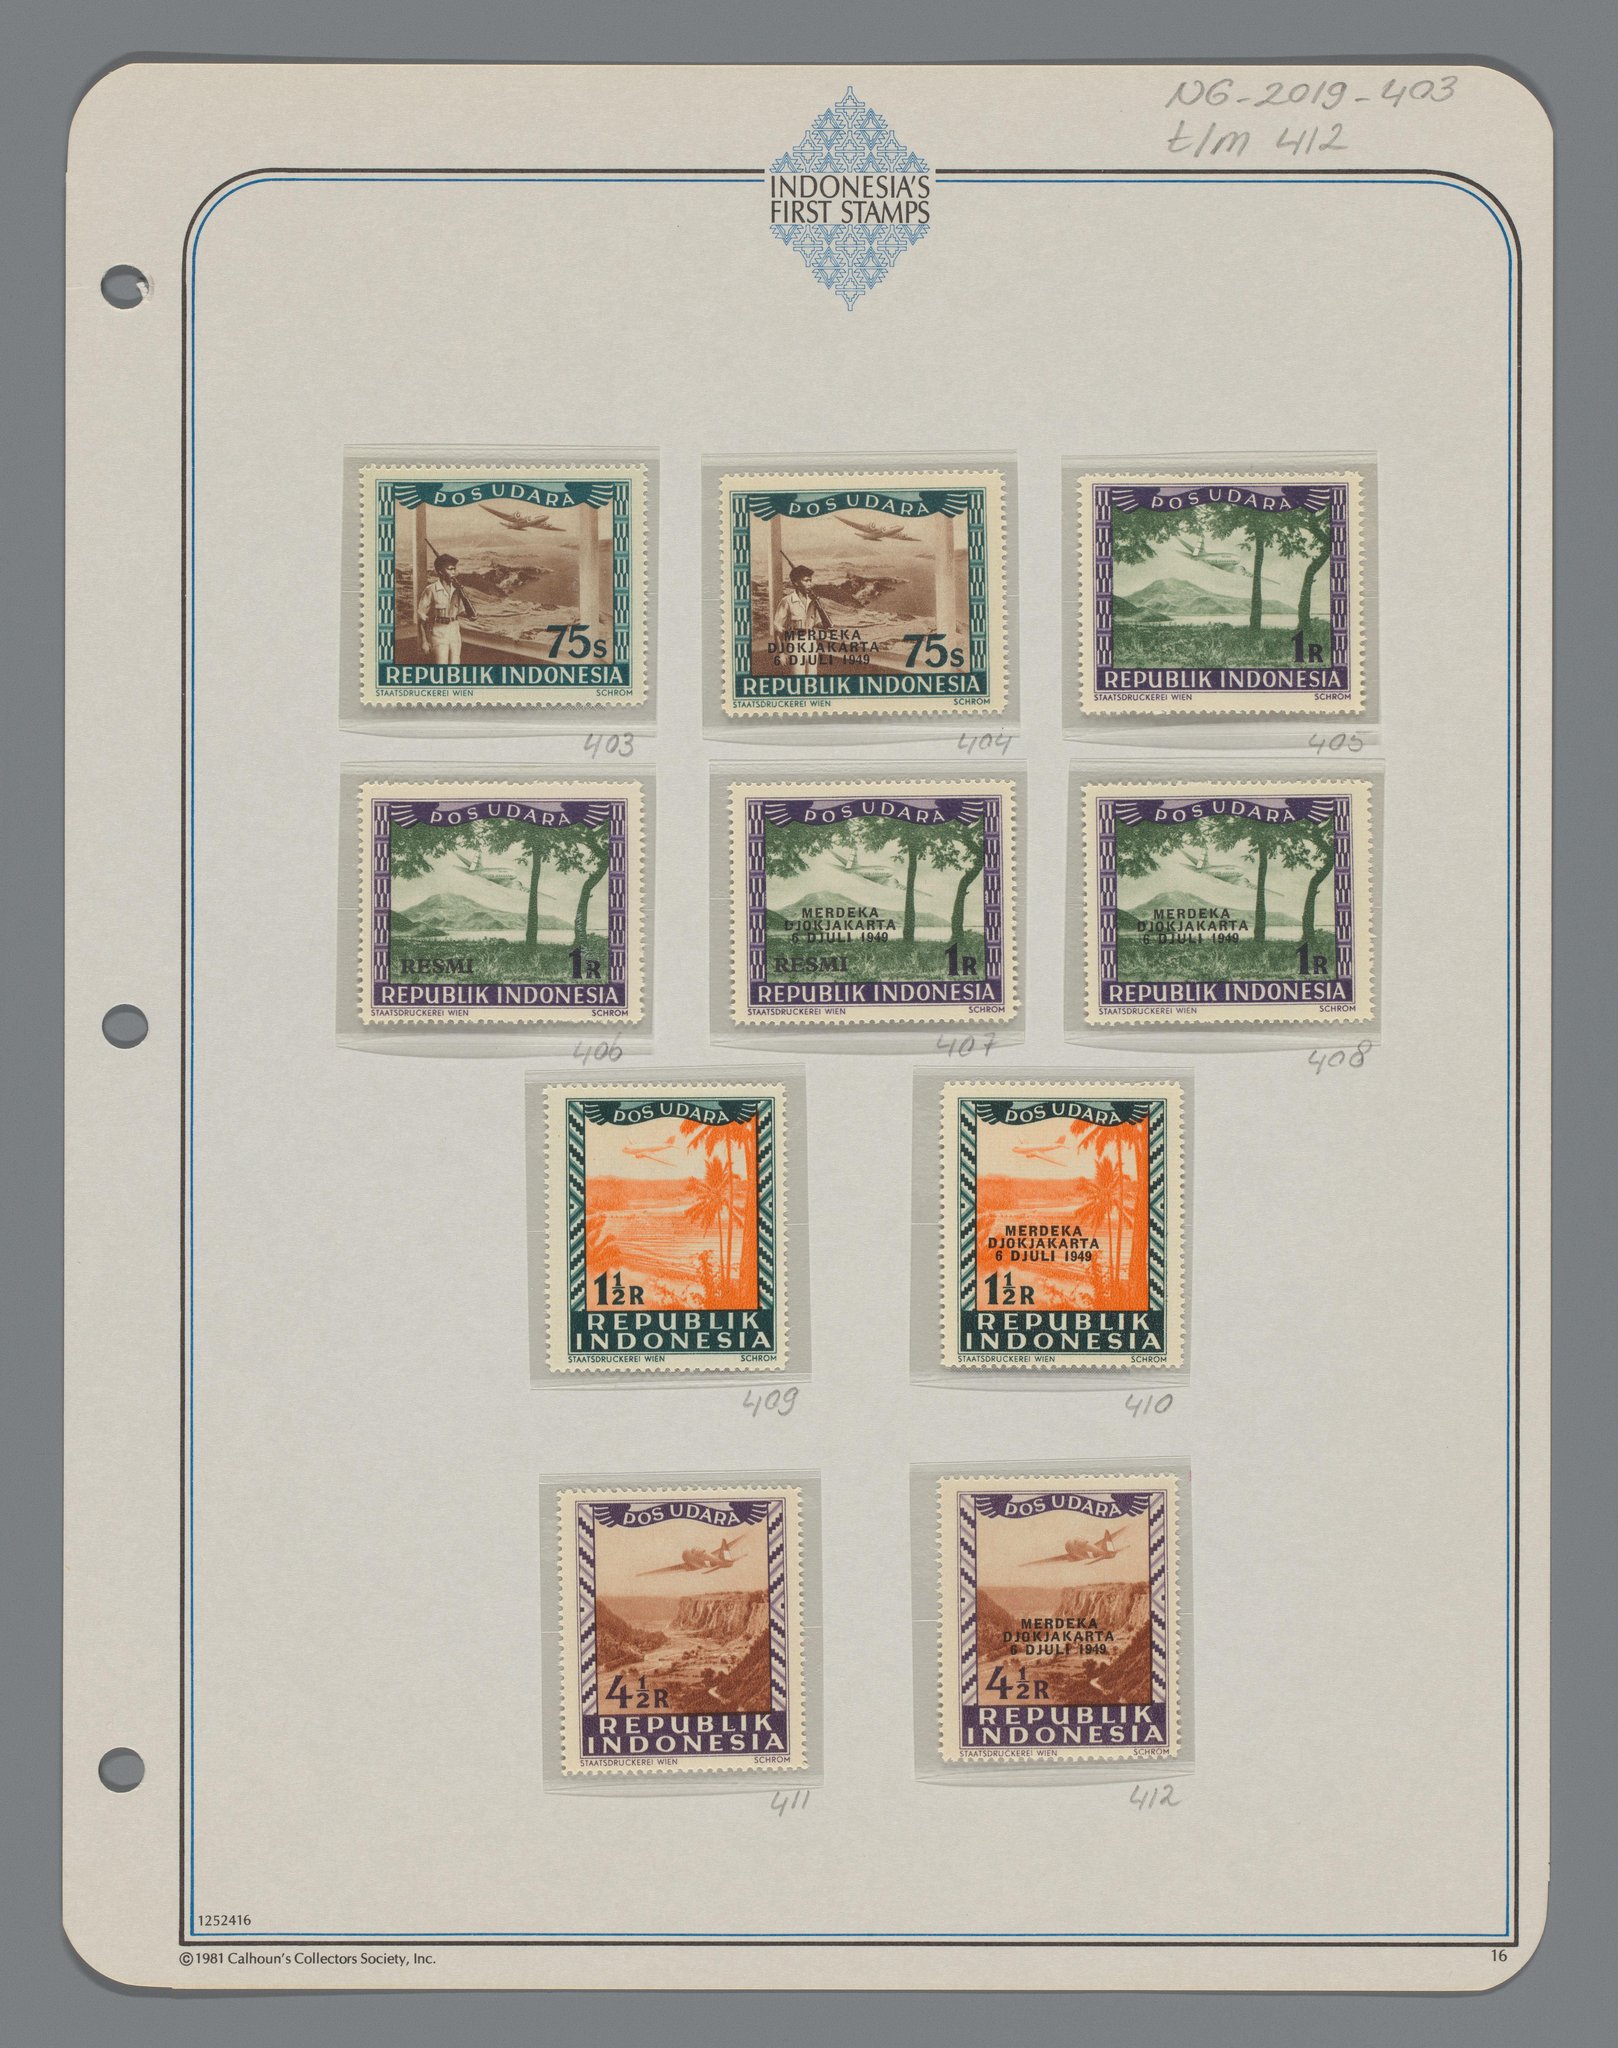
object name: postage stamp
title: Postzegel Republik Indonesia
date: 1949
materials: paper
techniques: photoaquatint, engraving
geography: vienna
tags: indonesia